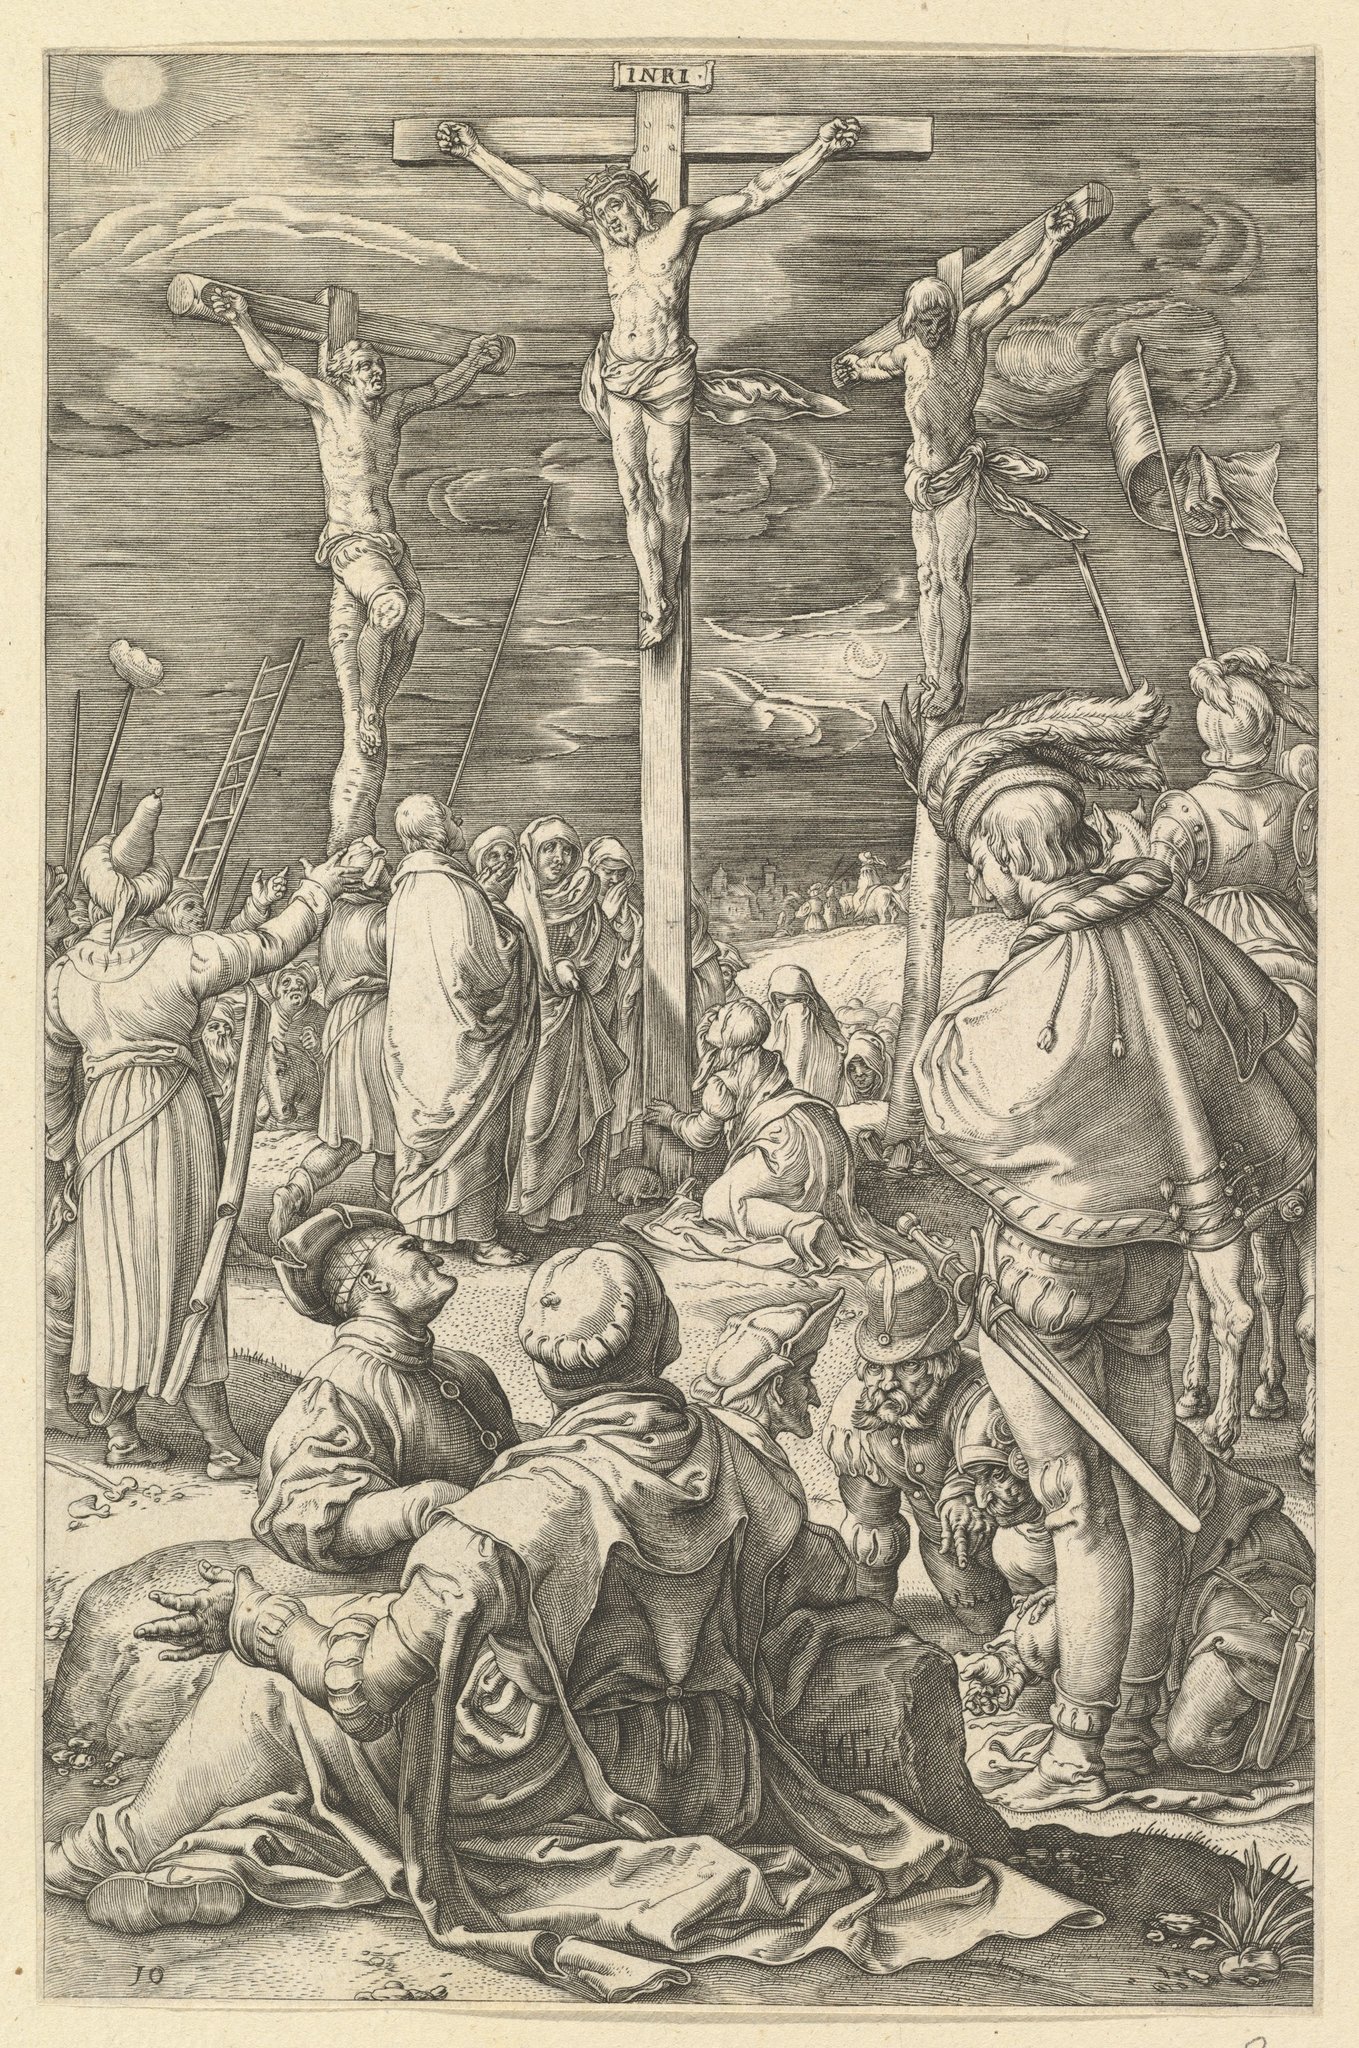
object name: print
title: Christ on the Cross, from "The Passion of Christ"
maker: Anonymous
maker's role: artist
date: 1598-1617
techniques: engraving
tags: human figures,christ,cross